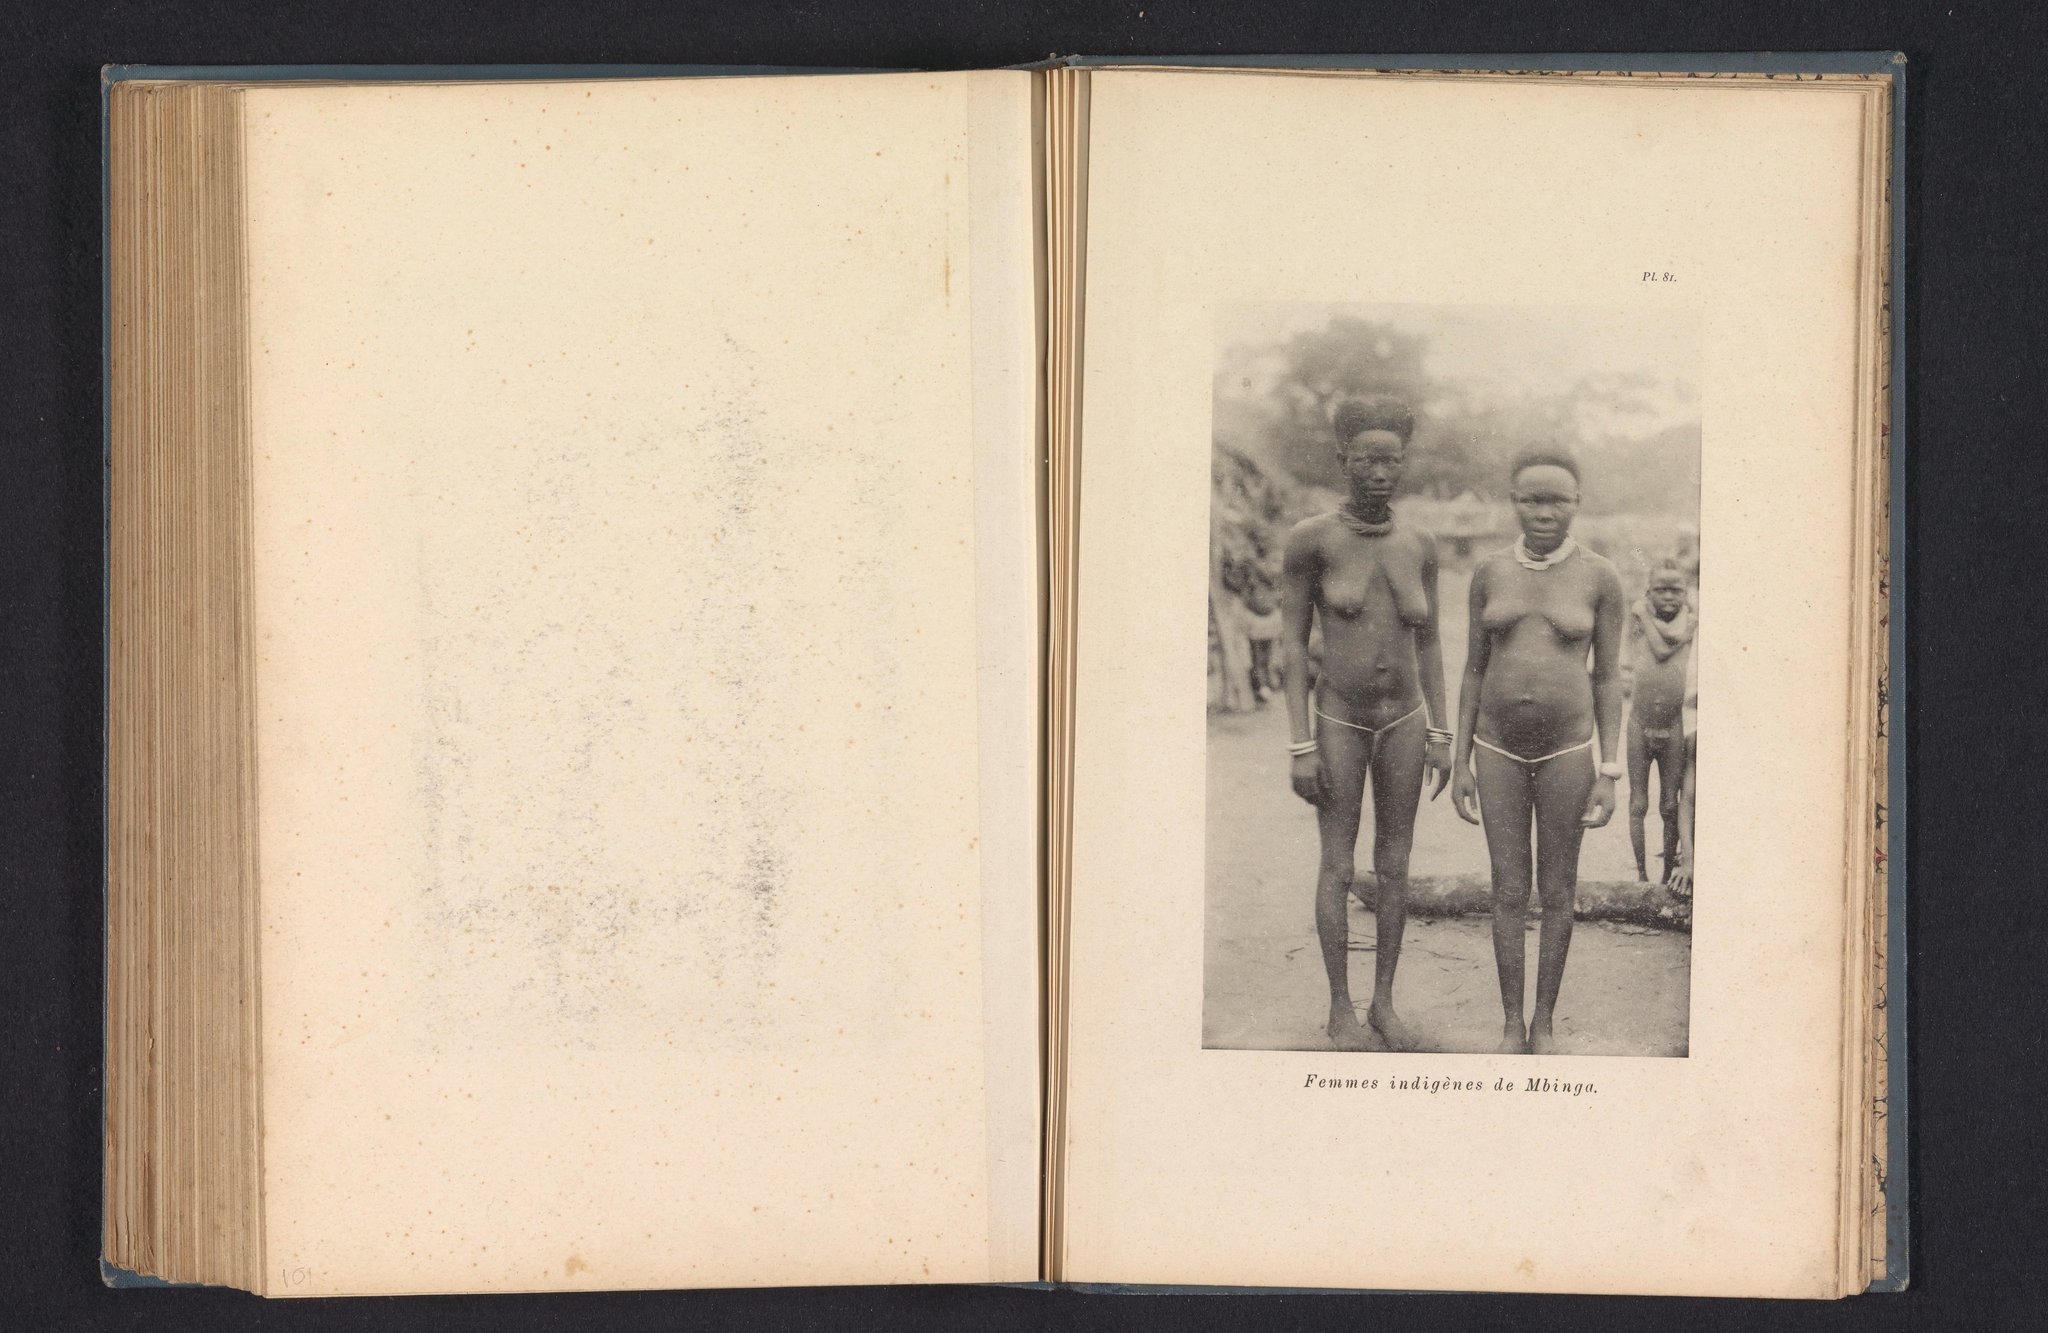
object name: page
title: Portret van twee vrouwen te Mbinga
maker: franz thonner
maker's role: botanicus, ontdekkingsreiziger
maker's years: 1863-1928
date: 1896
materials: paper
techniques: photograph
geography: mbinga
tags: adult woman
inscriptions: number: ‘Pl. 81.’